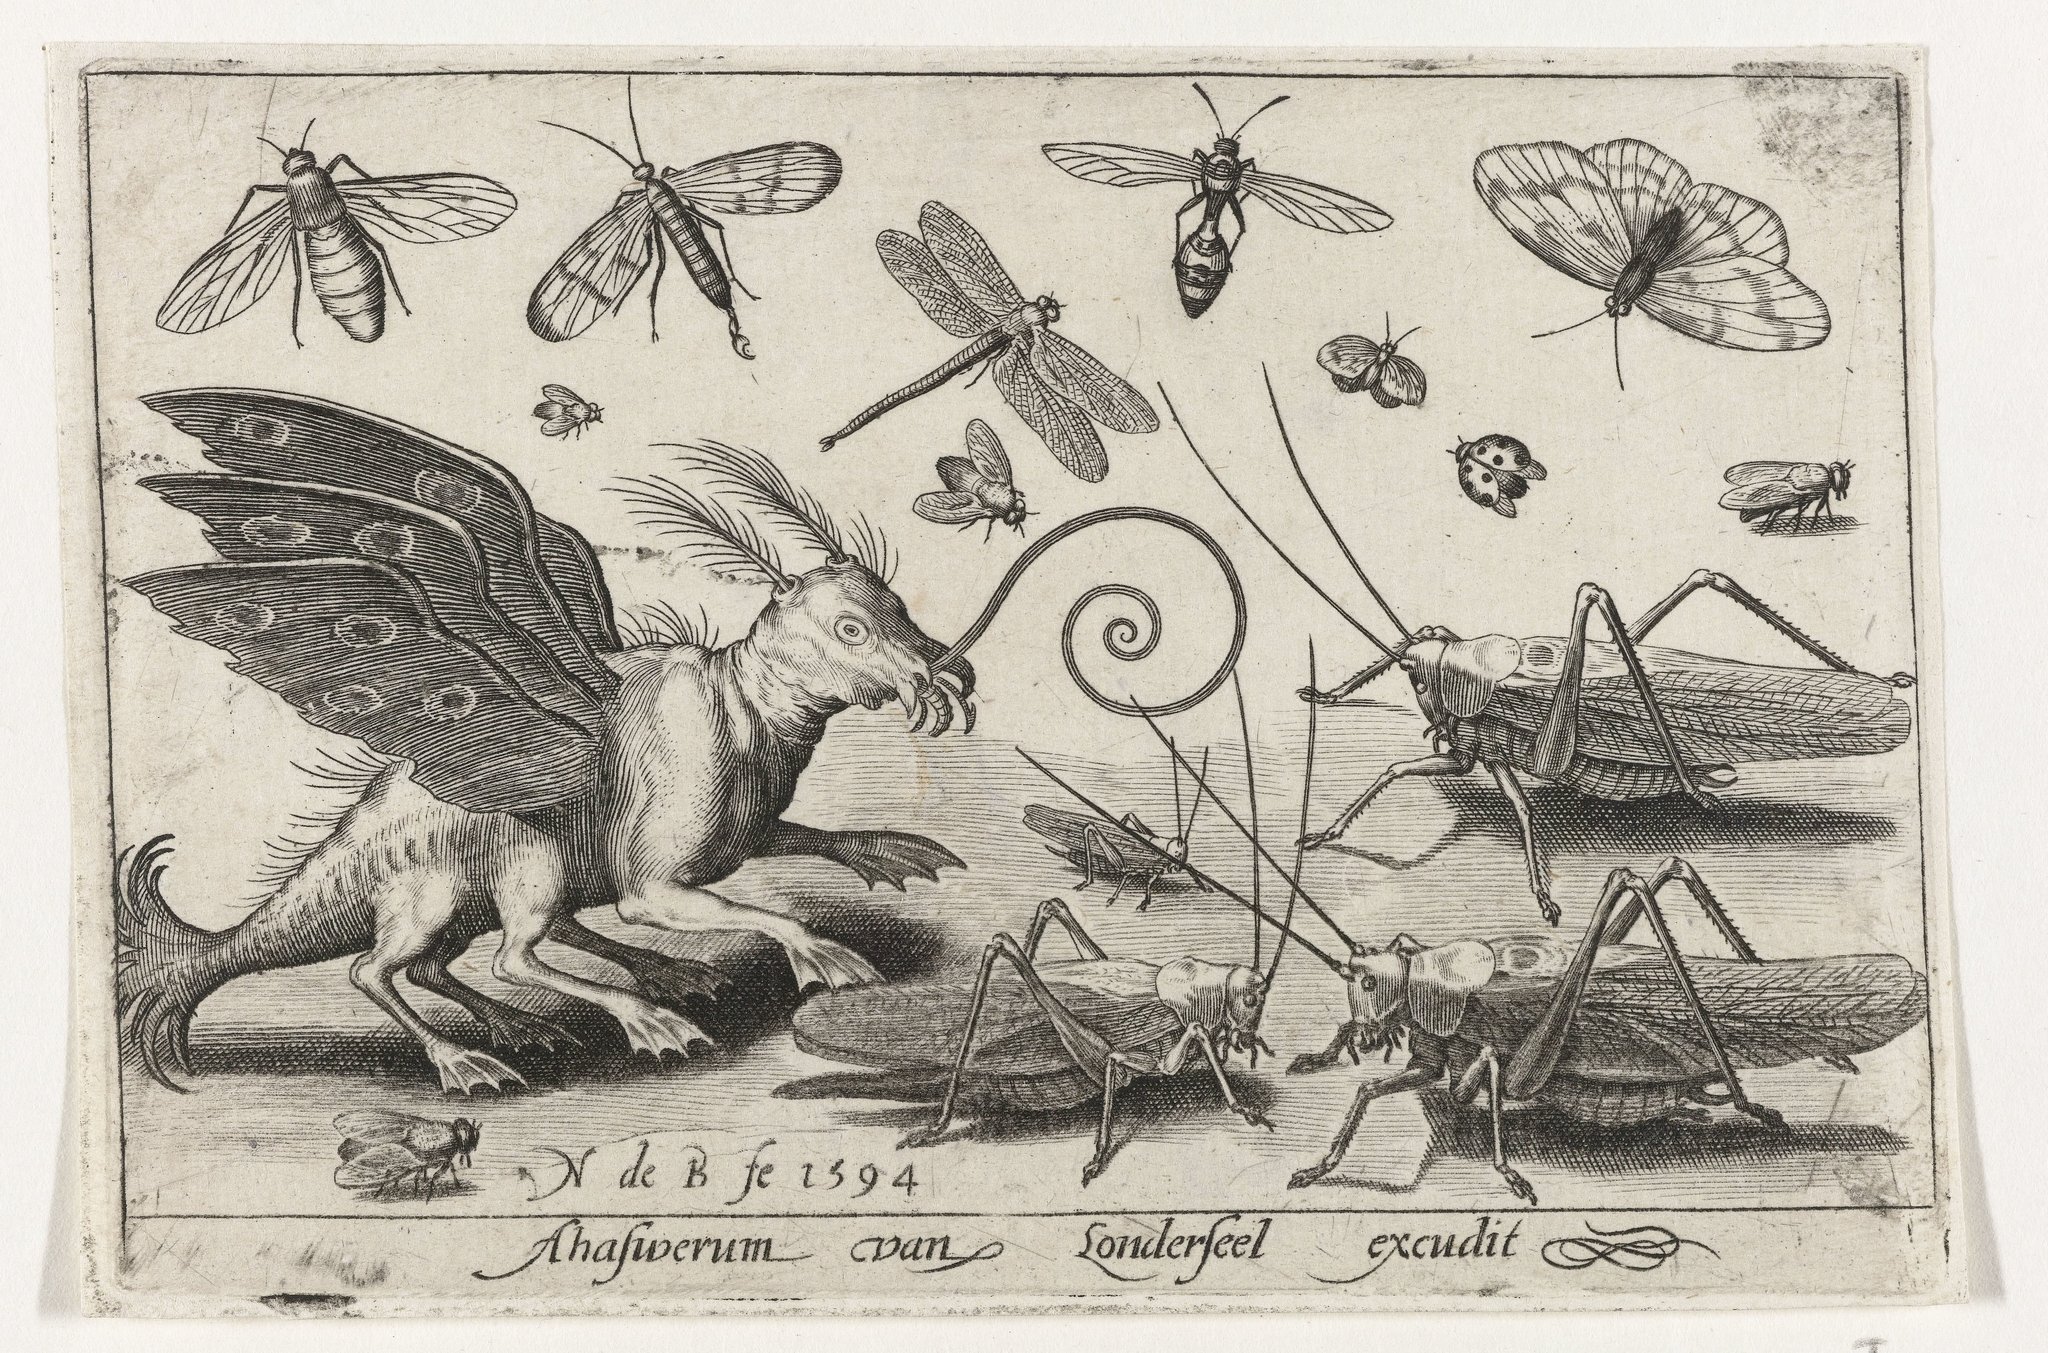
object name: print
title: Vogels en insecten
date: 1594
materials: paper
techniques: engraving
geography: antwerp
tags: fabulous animals (sometimes wrongly called 'grotesques'); 'mostri' (ripa) (+ ornamental variants of animals), insects: grass-hopper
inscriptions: collector's mark: Lugt 2228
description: Prent uit serie van twaalf prenten met vogels en insecten. Bij Hollstein zijn bladen van een andere serie prenten afgebeeld, zie De Groot 1988, p. 37.